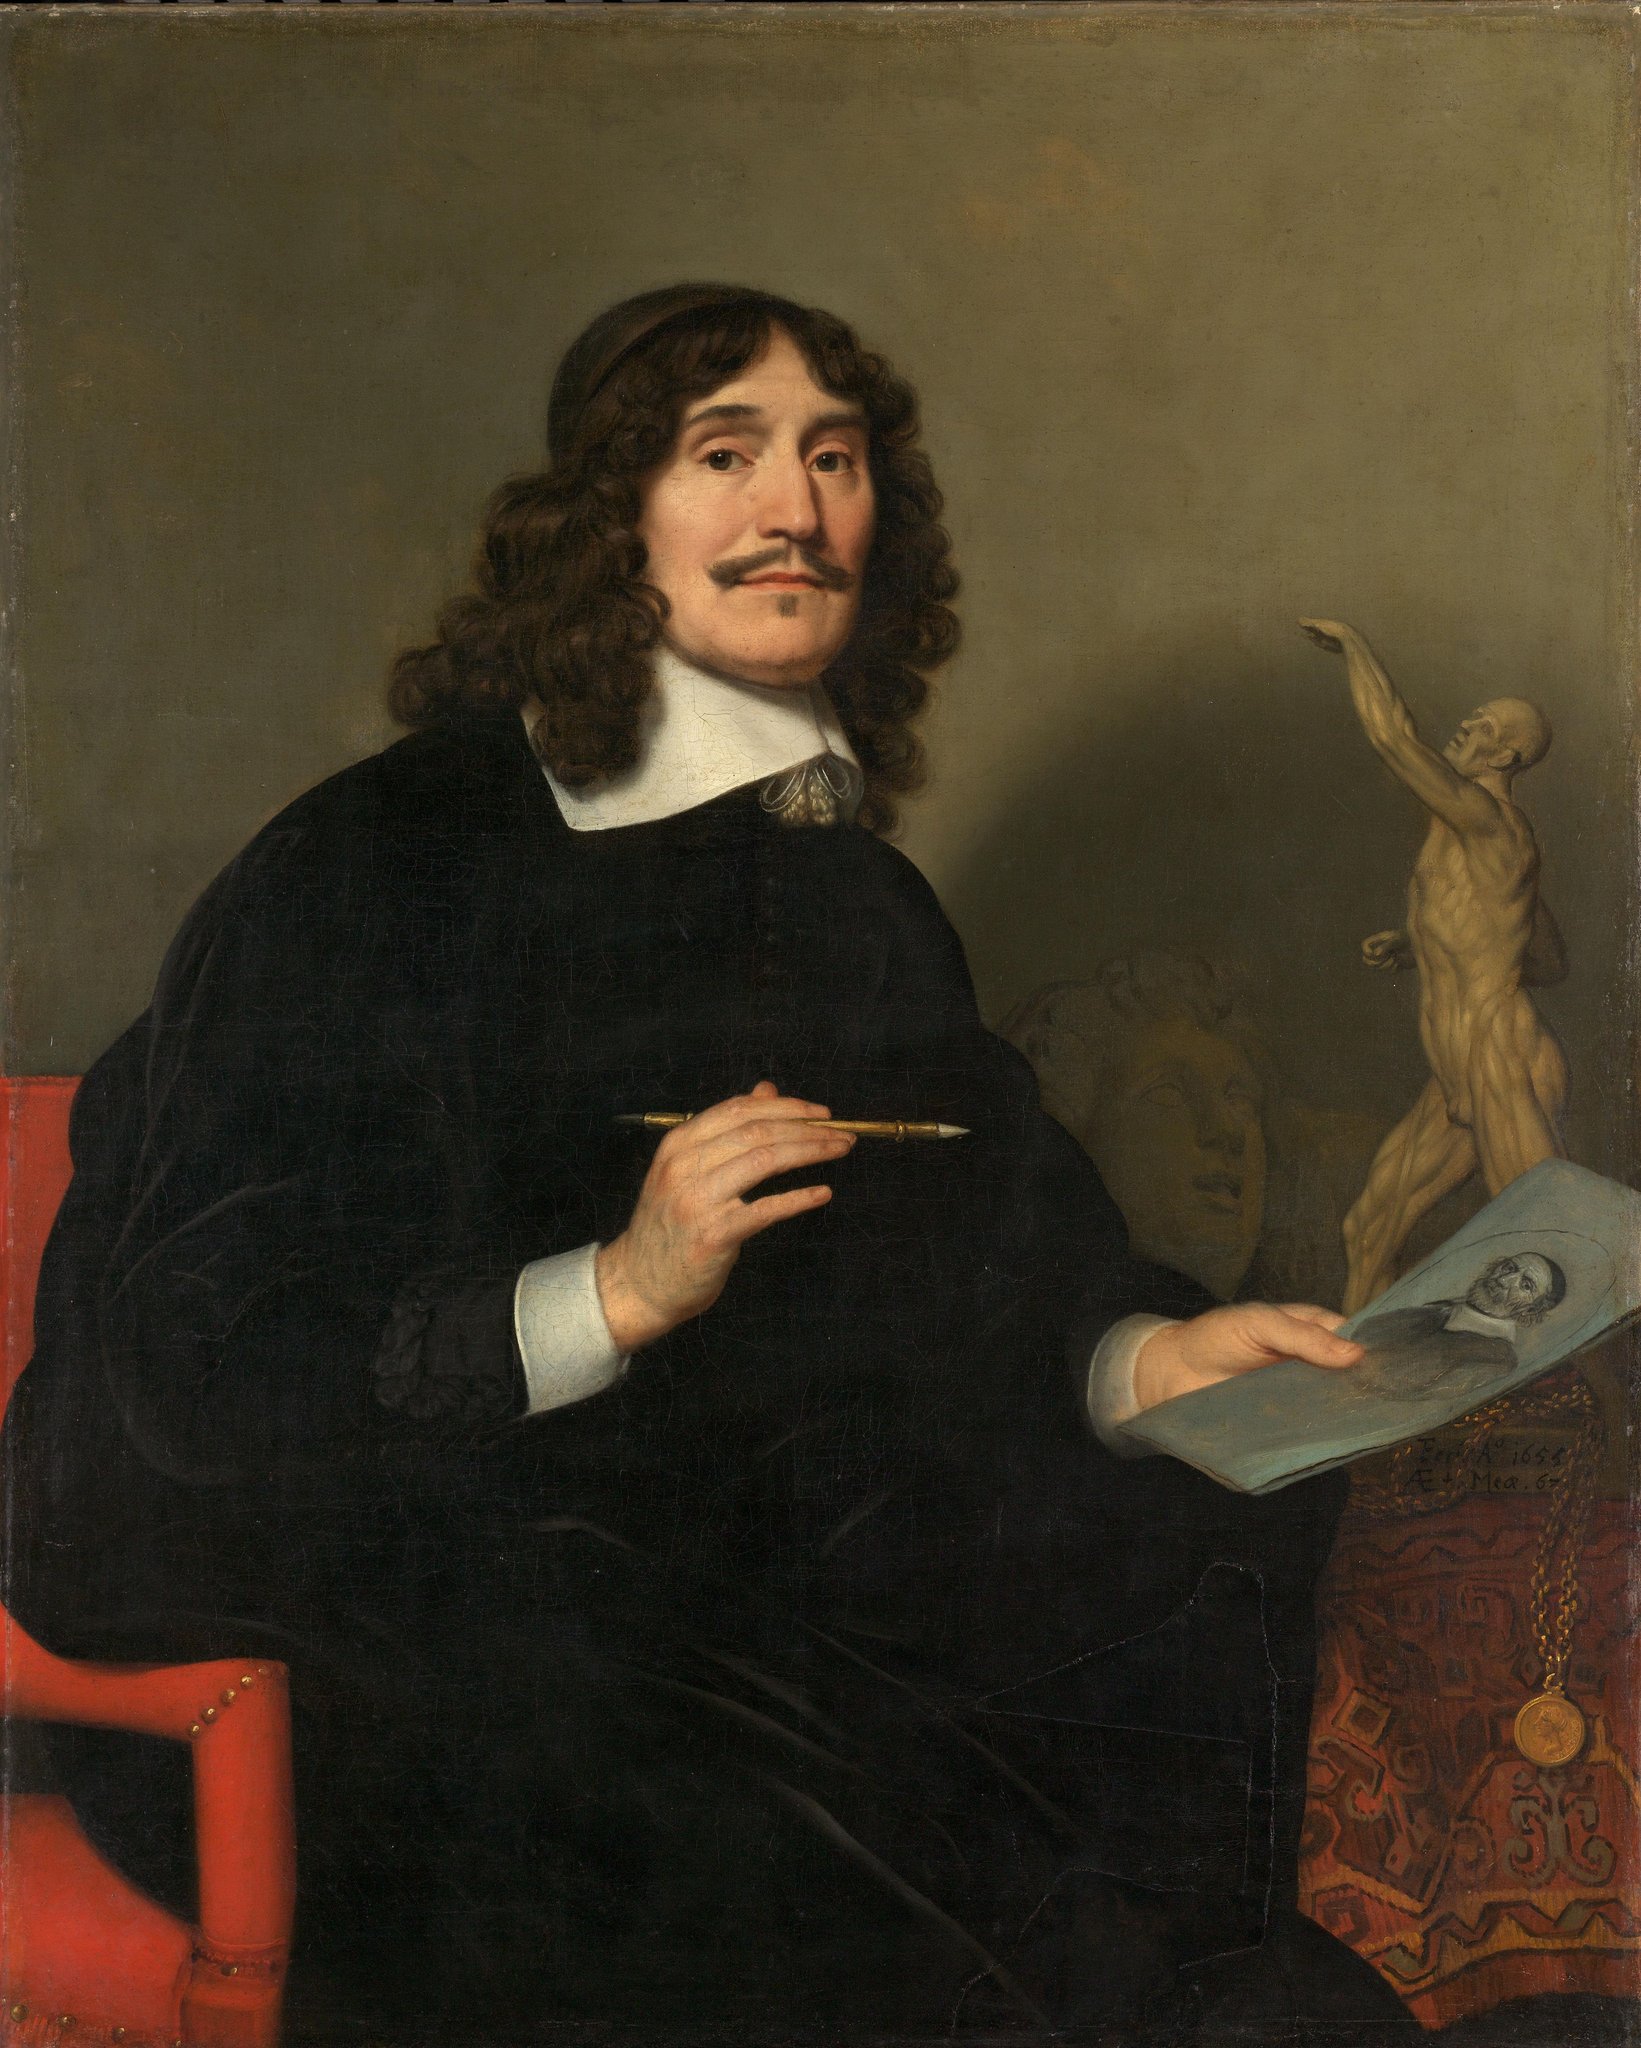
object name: painting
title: Portrait of an Artist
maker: gerard van honthorst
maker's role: draughtsman, painter, print maker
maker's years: 1592-1656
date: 1655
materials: canvas, oil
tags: historical persons, portrait, self-portrait of artist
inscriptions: date and inscription, centre right: ‘Feci Aº 1655. / Æt. Mea. 67.’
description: Portret van een kunstenaar. Kniestuk, zittend in een stoel achter een tafel. In de rechterhand een tekenpen, in de linkerhand een blad papier met een tekening (een portret van Abraham Bloemaert). Op de tafel een anatomisch model, een gipsen kop en een medaillon aan een ketting. Voorheen beschouwd als een zelfportret van Gerard van Honthorst. Pendant van SK-A-1480.